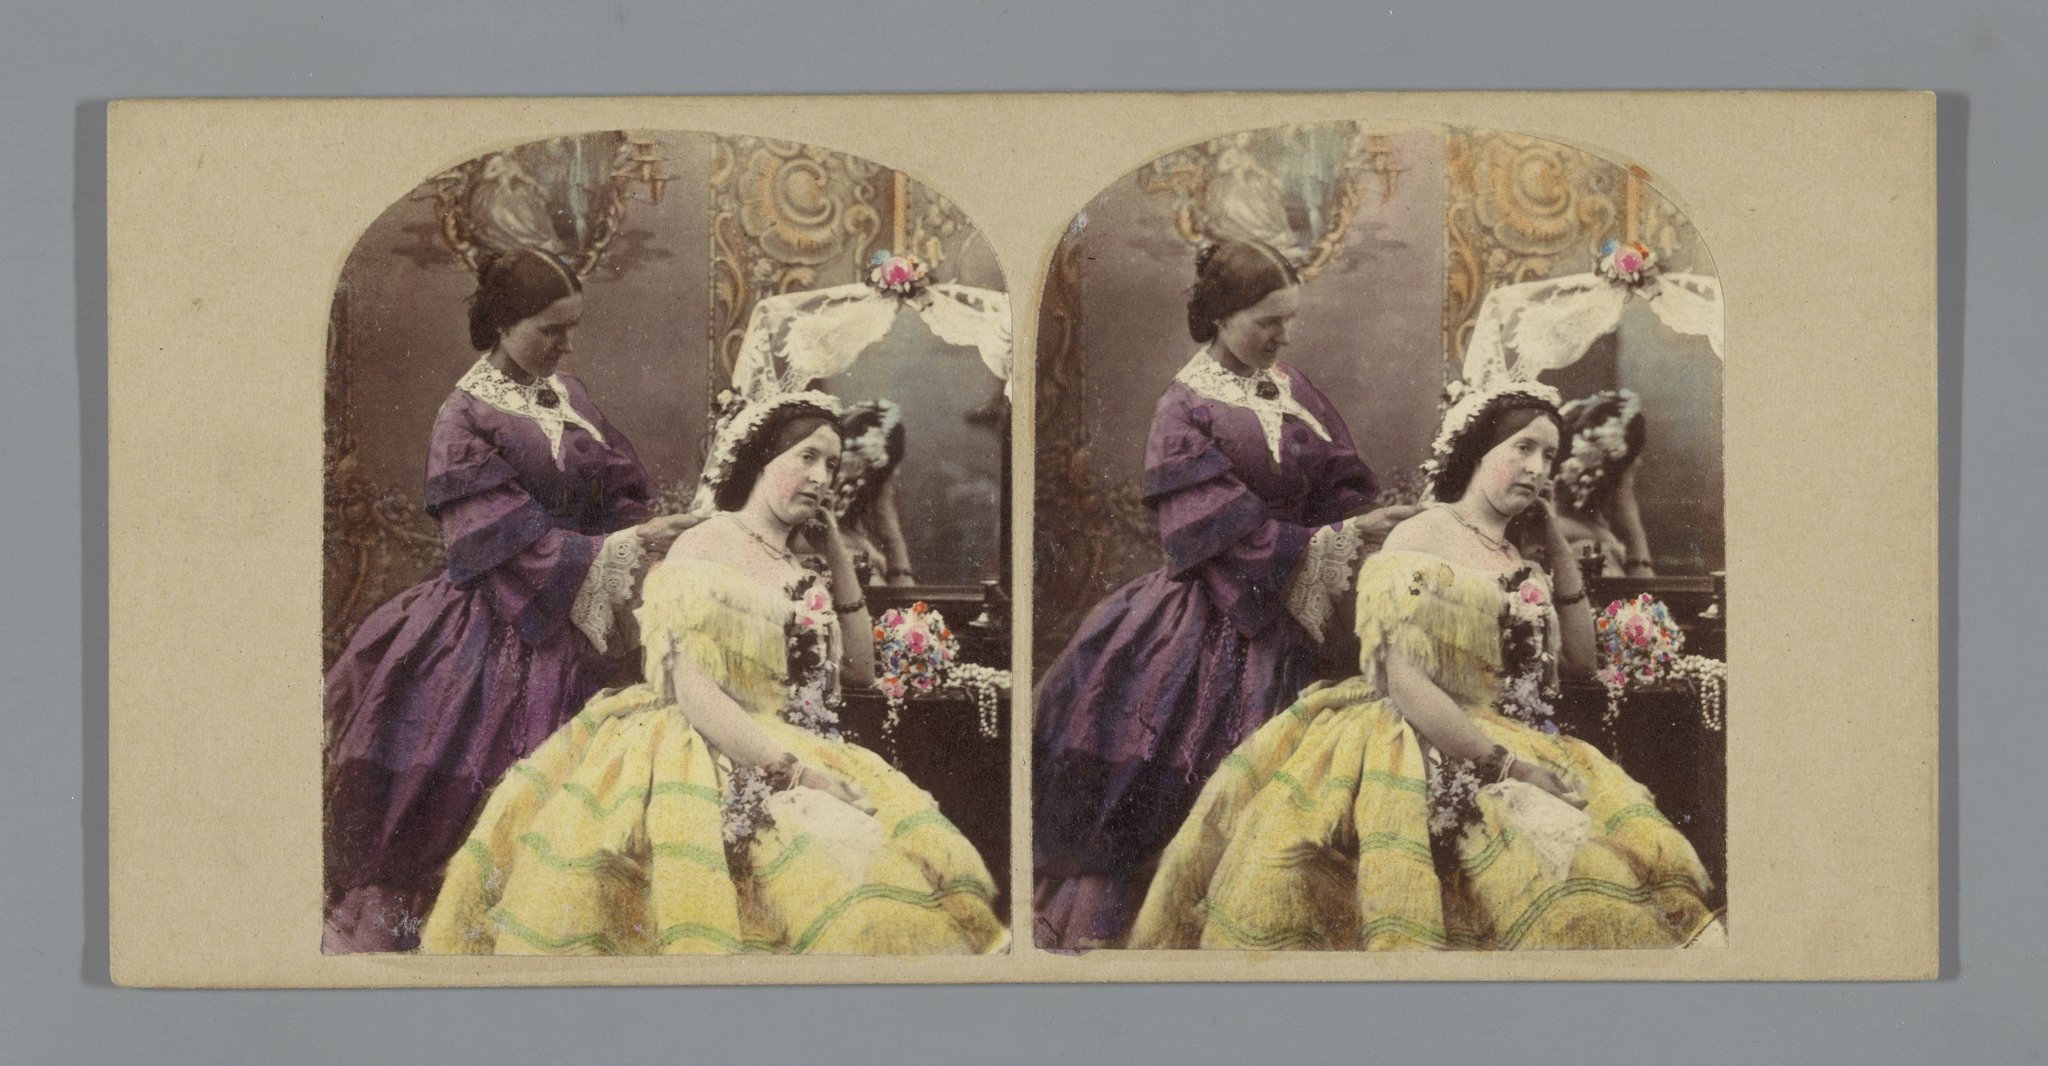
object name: stereograph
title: The Bride's Toilet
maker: hablot knight browne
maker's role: print maker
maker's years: 1815-1882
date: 1852-1863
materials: cardboard, paper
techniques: albumen print, hand coloring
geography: england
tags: dressing the bride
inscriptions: inscription: ‘zoz/ 1,50’